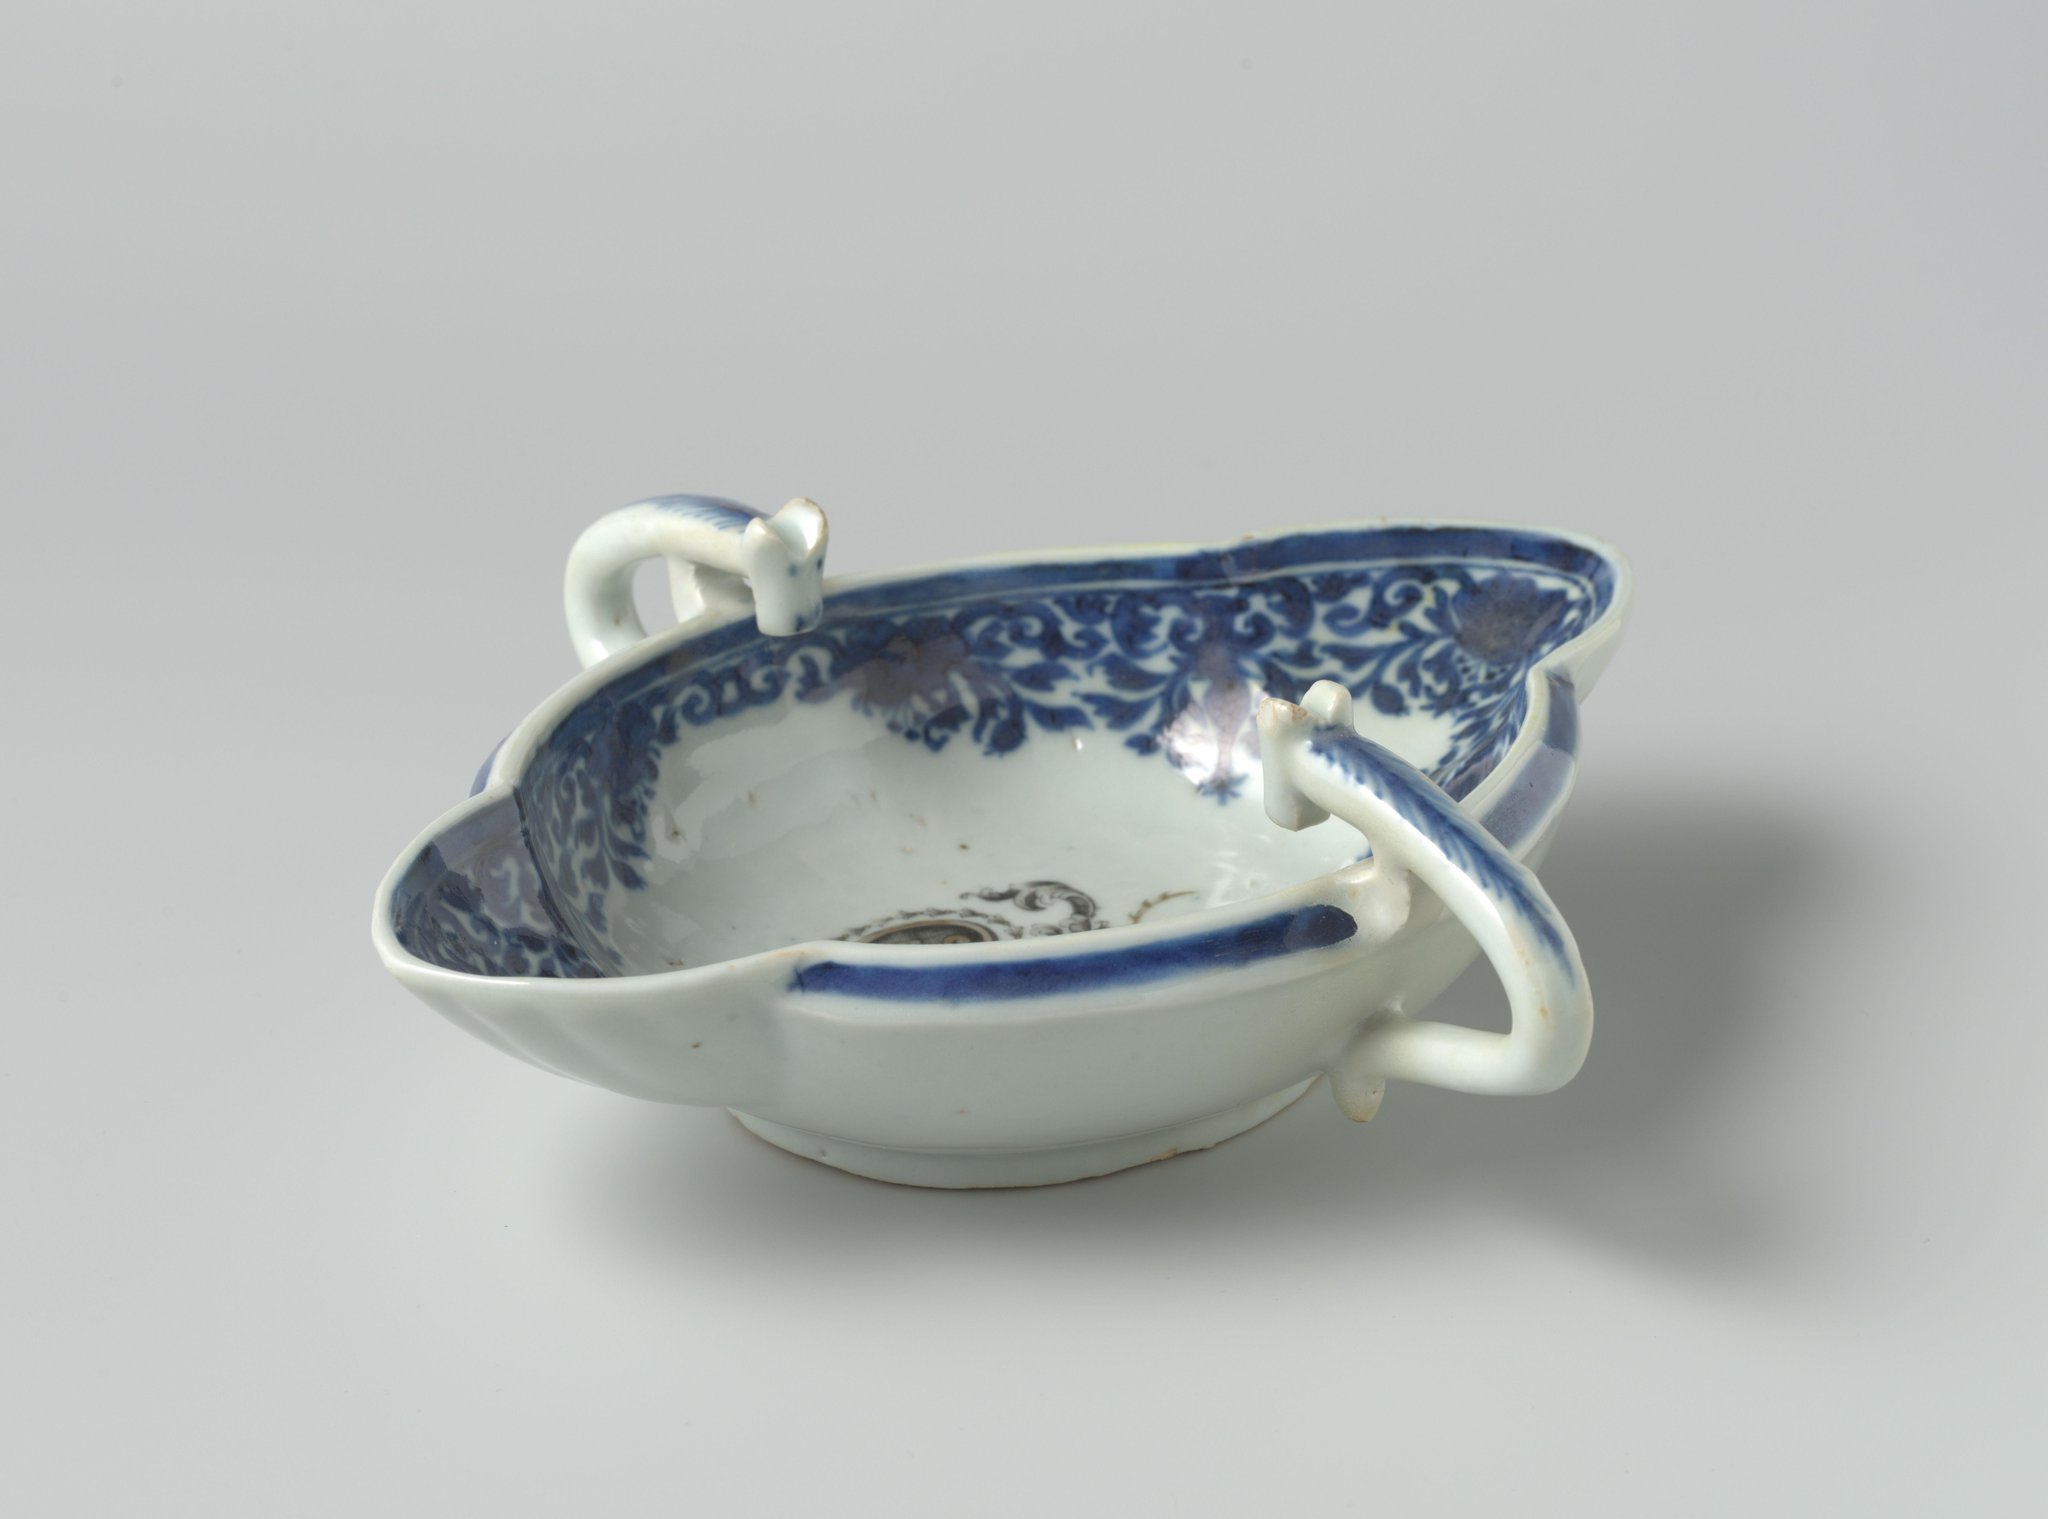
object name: sauceboat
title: Sauskom met het wapen van de familie Swellengrebel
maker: Anonymous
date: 1740-1750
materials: cobalt, glaze, gold, paint, porcelain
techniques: firing, forming, gilding, turning, vitrification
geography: china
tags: utrecht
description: Ovale sauskom, de rand in de vorm van een vierpas. De hoge, opstaande oren staan kas op de lange zijden van de kom. Beschilderd in onderglazuur blauw en met zwart en goud op het glazuur. Ronde de binnenwand een brede band met bandwerk en bloemranken in blauw met goud, in het centrum het wapen van de familie Swellengrebel in zwart en goud: Franse lelie op een ovaal schild en een gewei boven een kroon als helmteken. Wapenporselein in blauw-wit en emailkleuren.